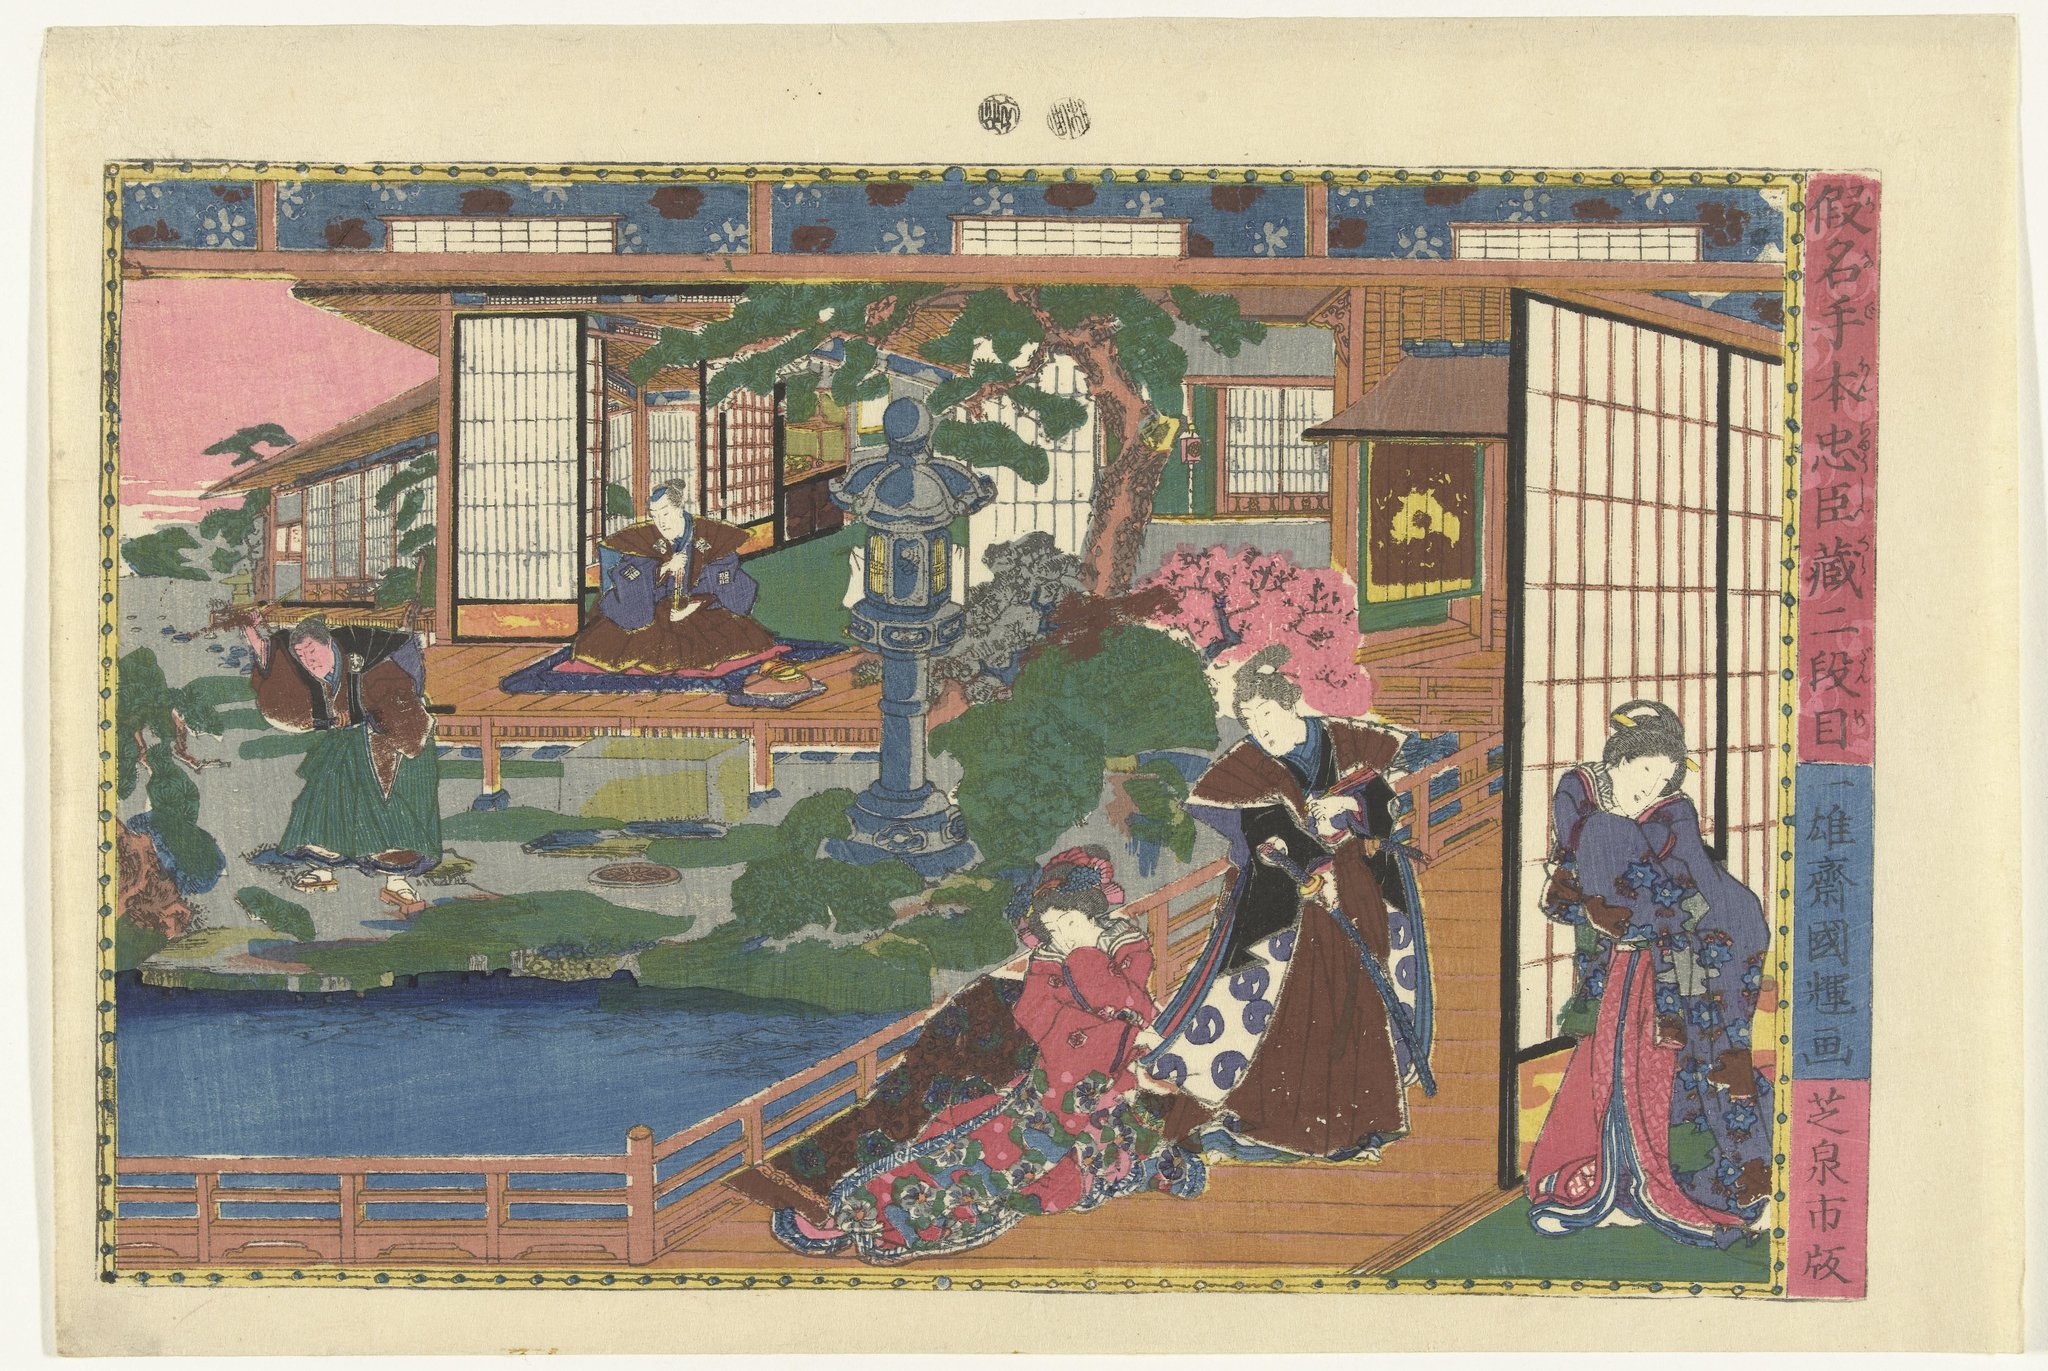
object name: print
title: Kanadehon Chushigura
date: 1851-1853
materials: paper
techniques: woodcut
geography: japan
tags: housing, eavesdropper, loggia, verandah, porch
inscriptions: collector's mark: Lugt 2228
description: Man en vrouw op veranda, afgeluisterd door vrouw bij schuifwand; op de achtergrond een man zittend op veranda, kijkend naar man in tuin.